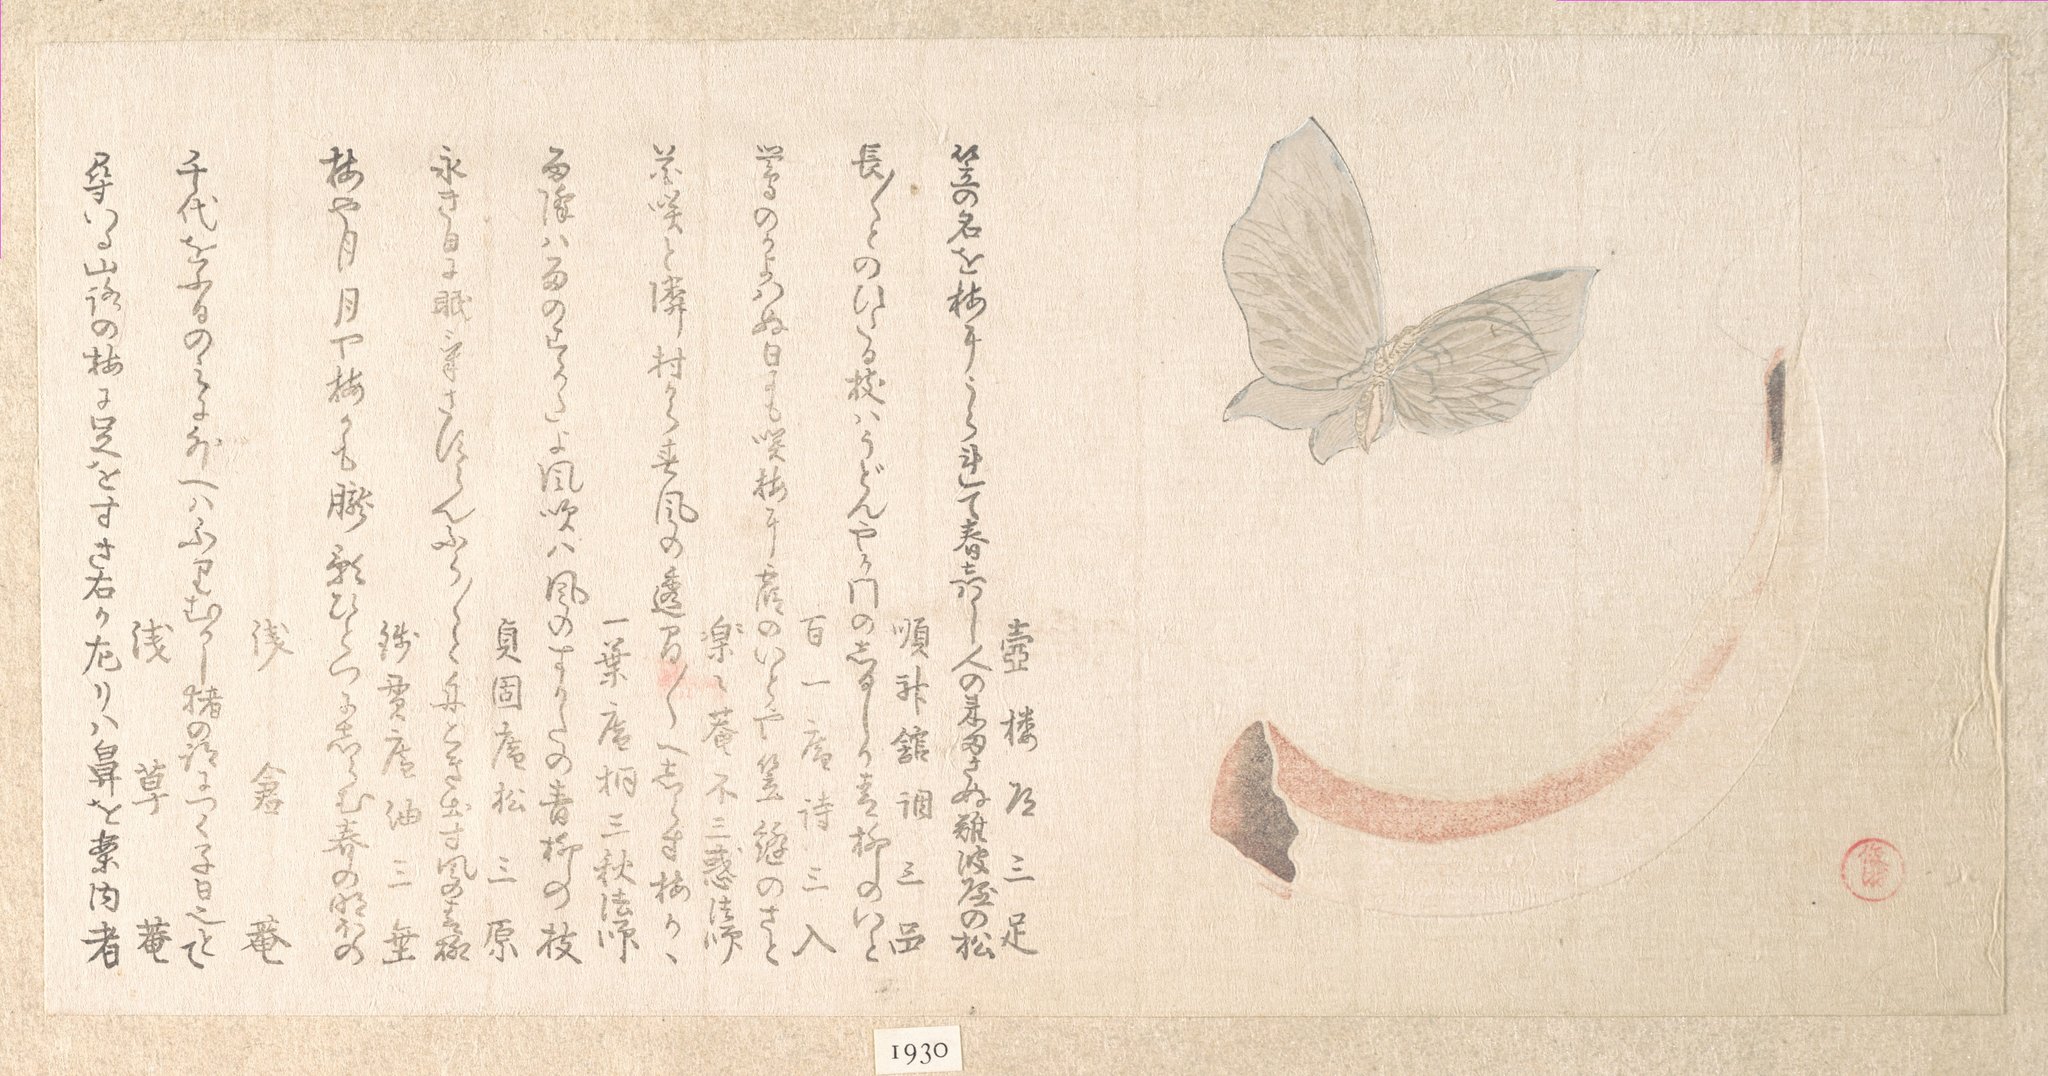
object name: print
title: Flower-Vase of Horn and a Butterfly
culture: japanese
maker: kubo shunman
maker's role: artist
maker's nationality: japanese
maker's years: 1757-1820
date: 1801-1900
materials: ink, paper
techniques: surimono, woodblock print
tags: horns,butterflies